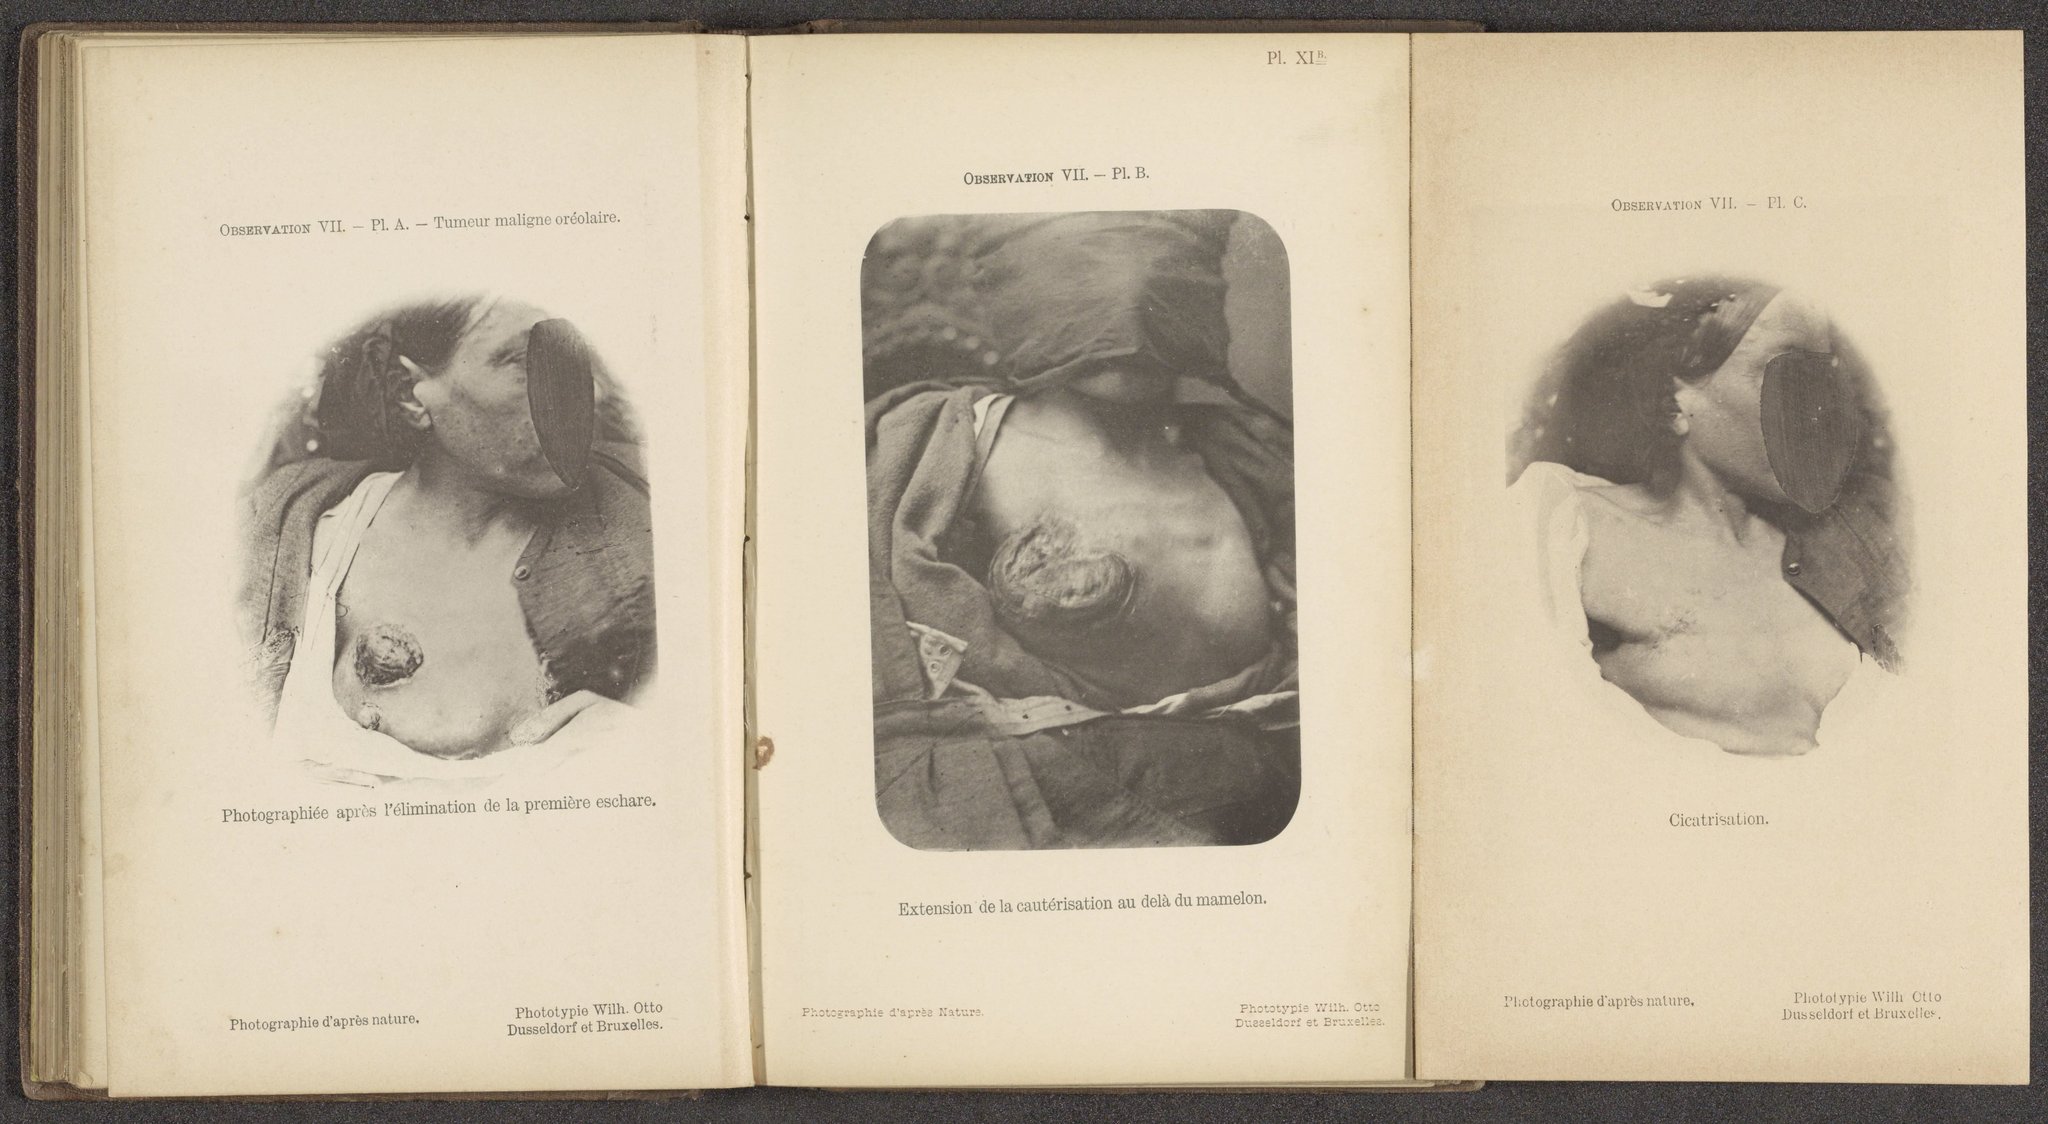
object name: page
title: Vrouw met een litteken op haar borst na de verwijdering kwaadaardige tumor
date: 1874-1884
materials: paper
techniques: photograph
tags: infections and wounds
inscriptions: inscription: ‘Observation VII. - Pl. C. / Cicatrisation.’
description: Onderdelen 13 en 14 vormen een leporello.